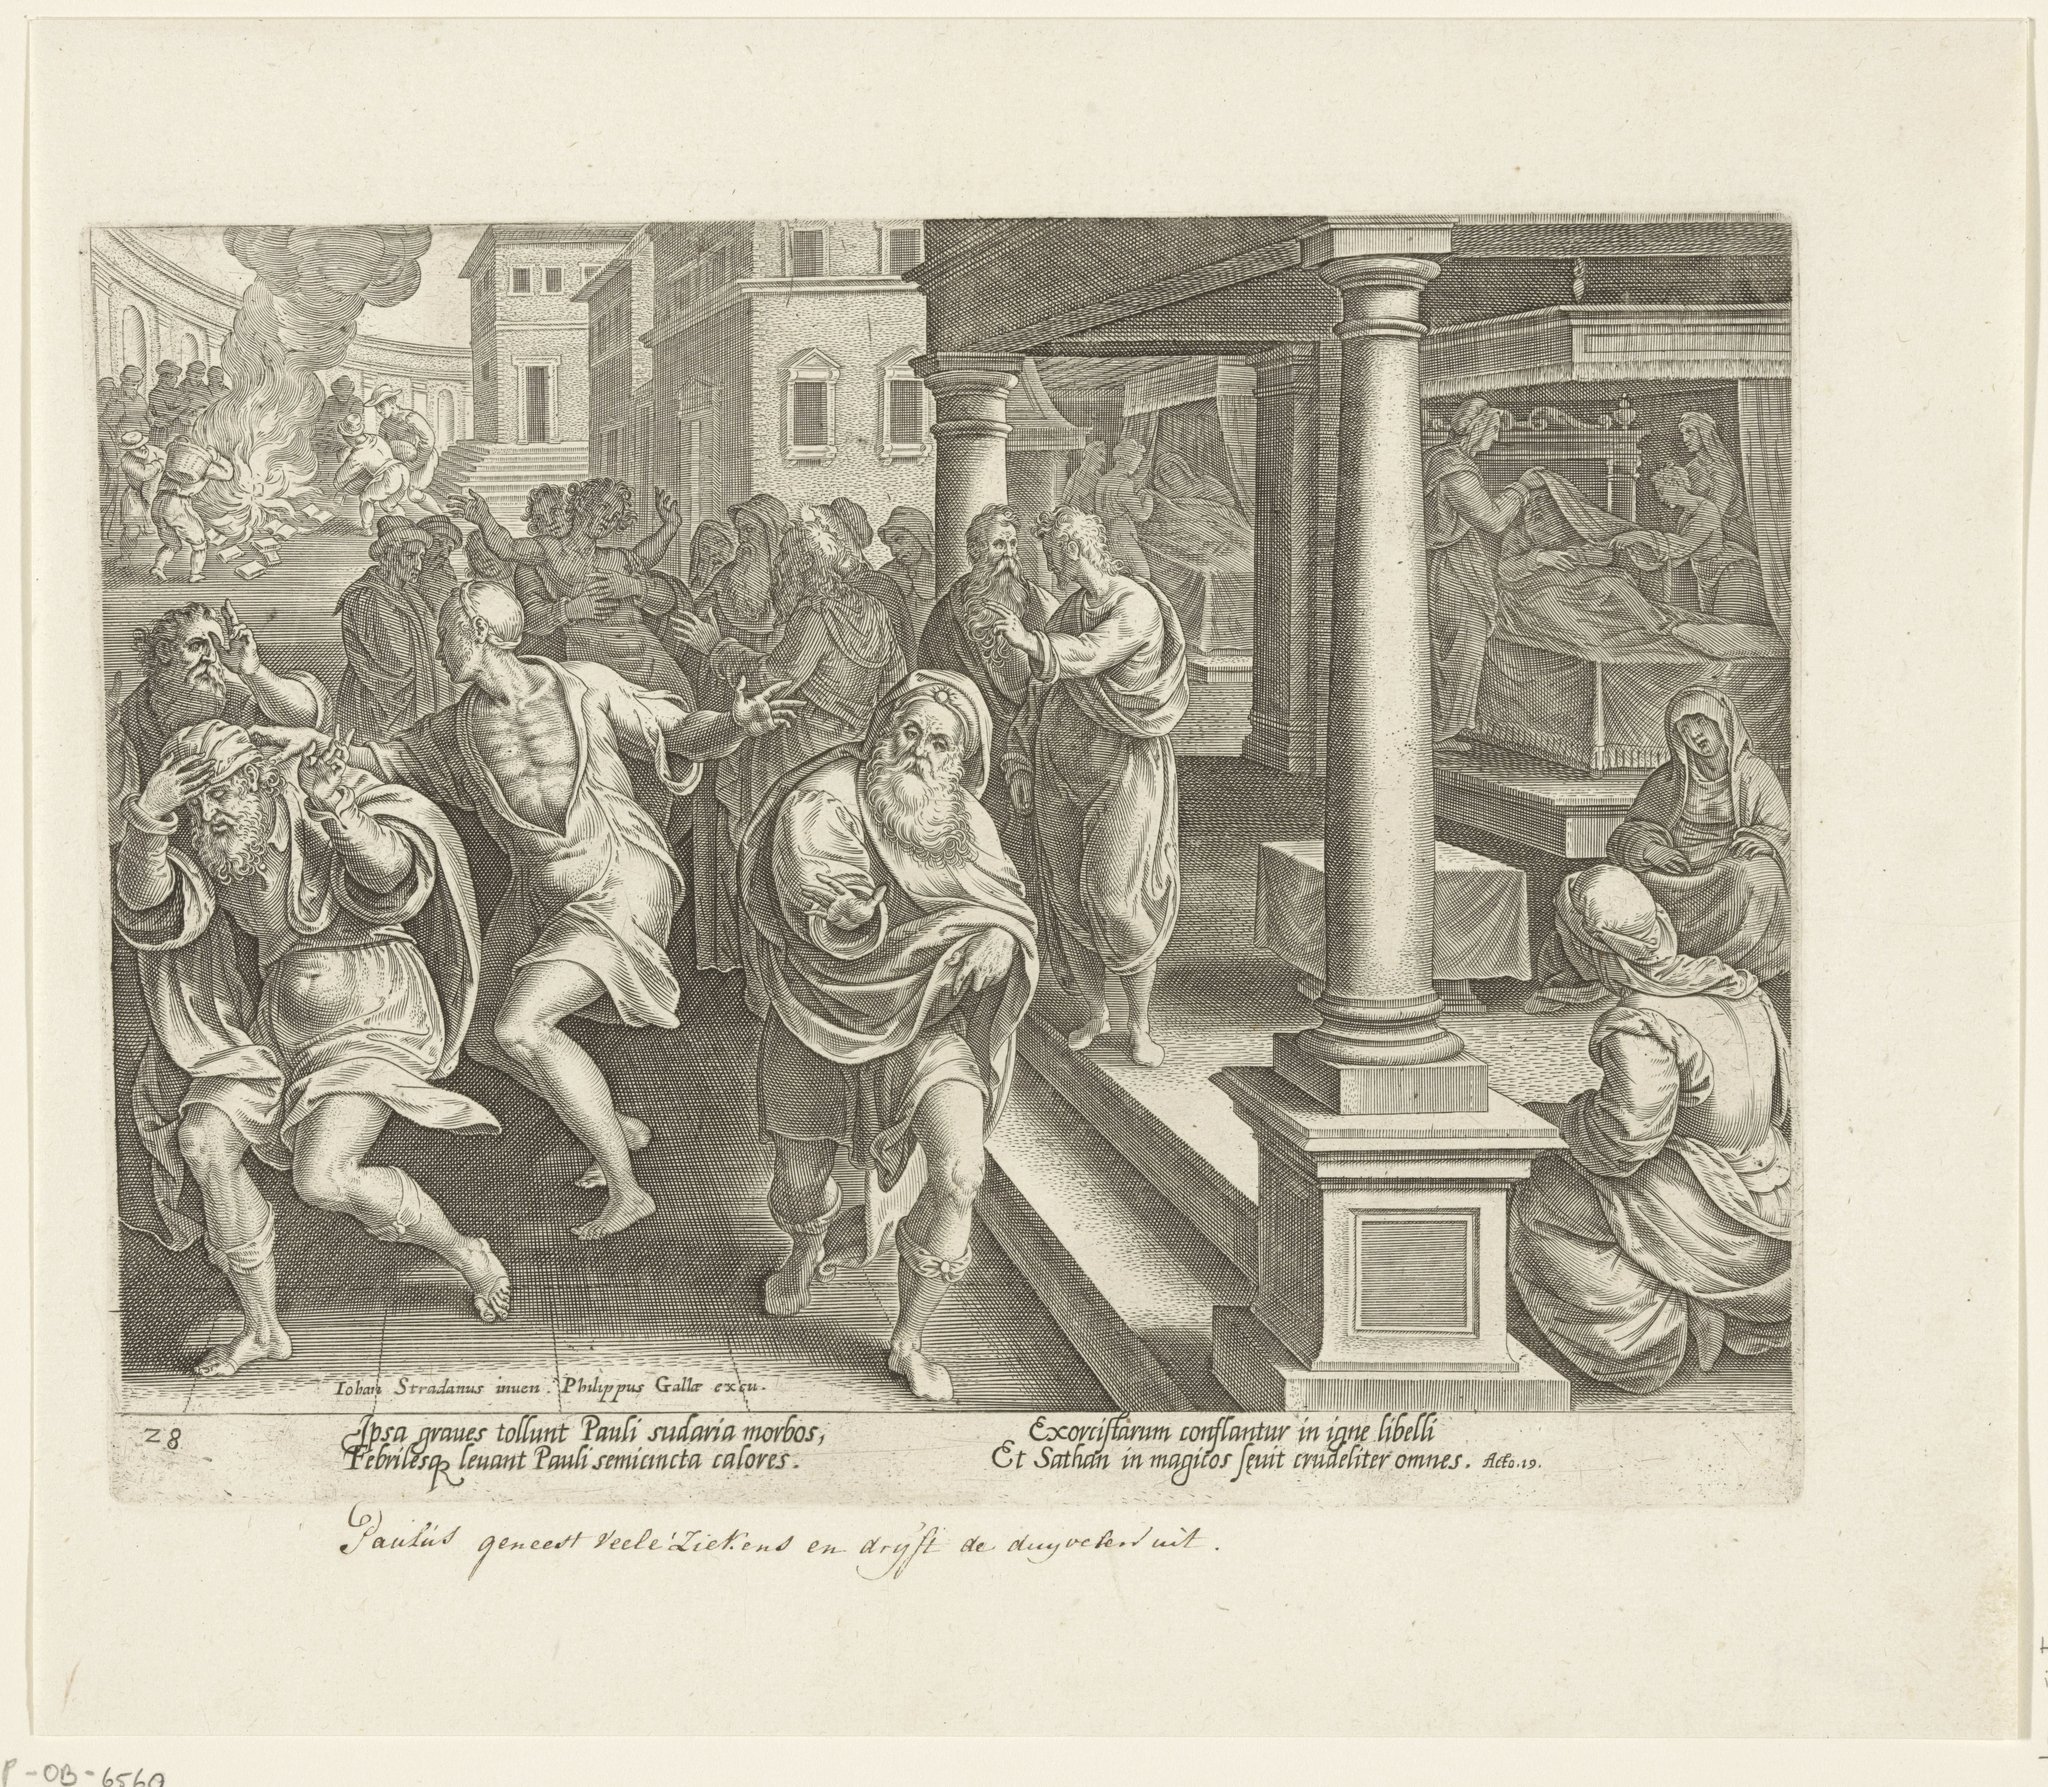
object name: print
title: Paulus drijft de boze geesten uit in Efese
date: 1582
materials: paper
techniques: engraving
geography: antwerp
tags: the ephesians burn the exorcists' books in public, seven exorcists, sons of sceva, are beaten by a man with an evil spirit, and flee, paul's handkerchiefs and aprons cure the sick and possessed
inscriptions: collector's mark: Lugt 2228, caption: ‘Paulus geneest veele ziekens en drijft de duyvelen uit’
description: Centraal drijft de apostel Paulus een boze geest uit het lichaam van een krankzinnige. Rondom hem vluchten magiërs en hogepriesters die hetzelfde hadden geprobeerd maar faalden. In de achtergrond verbranden deze magiërs hun boeken en bekeren ze zich tot het Christendom. De prent heeft een Latijns onderschrift en maakt deel uit van een 34-delige serie met als onderwerp de Handelingen van de apostelen.